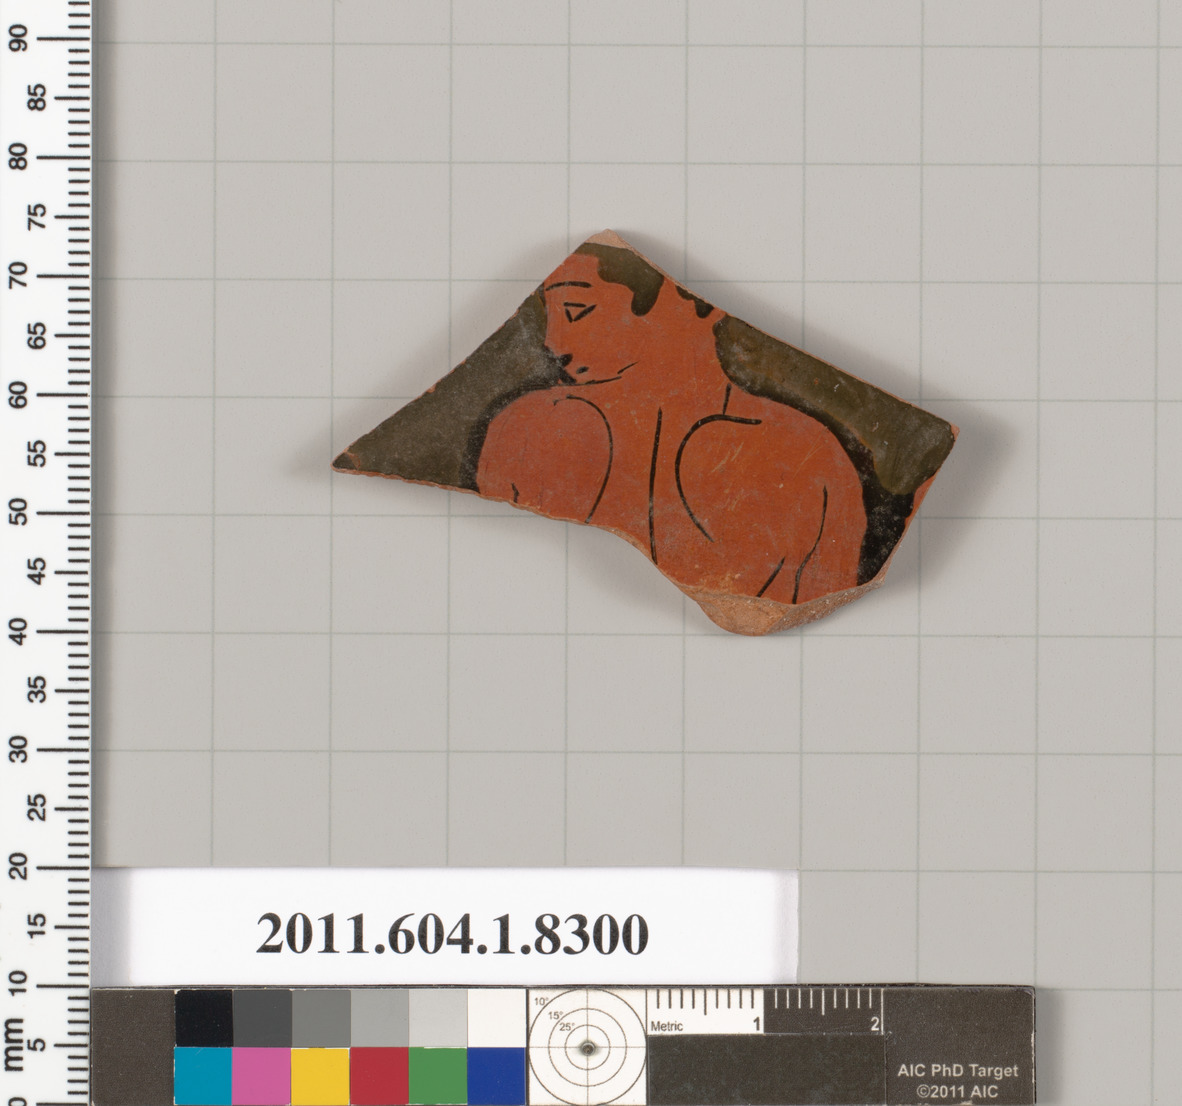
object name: kylix fragment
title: Terracotta fragment of a kylix (drinking cup)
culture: greek, attic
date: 451-500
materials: terracotta